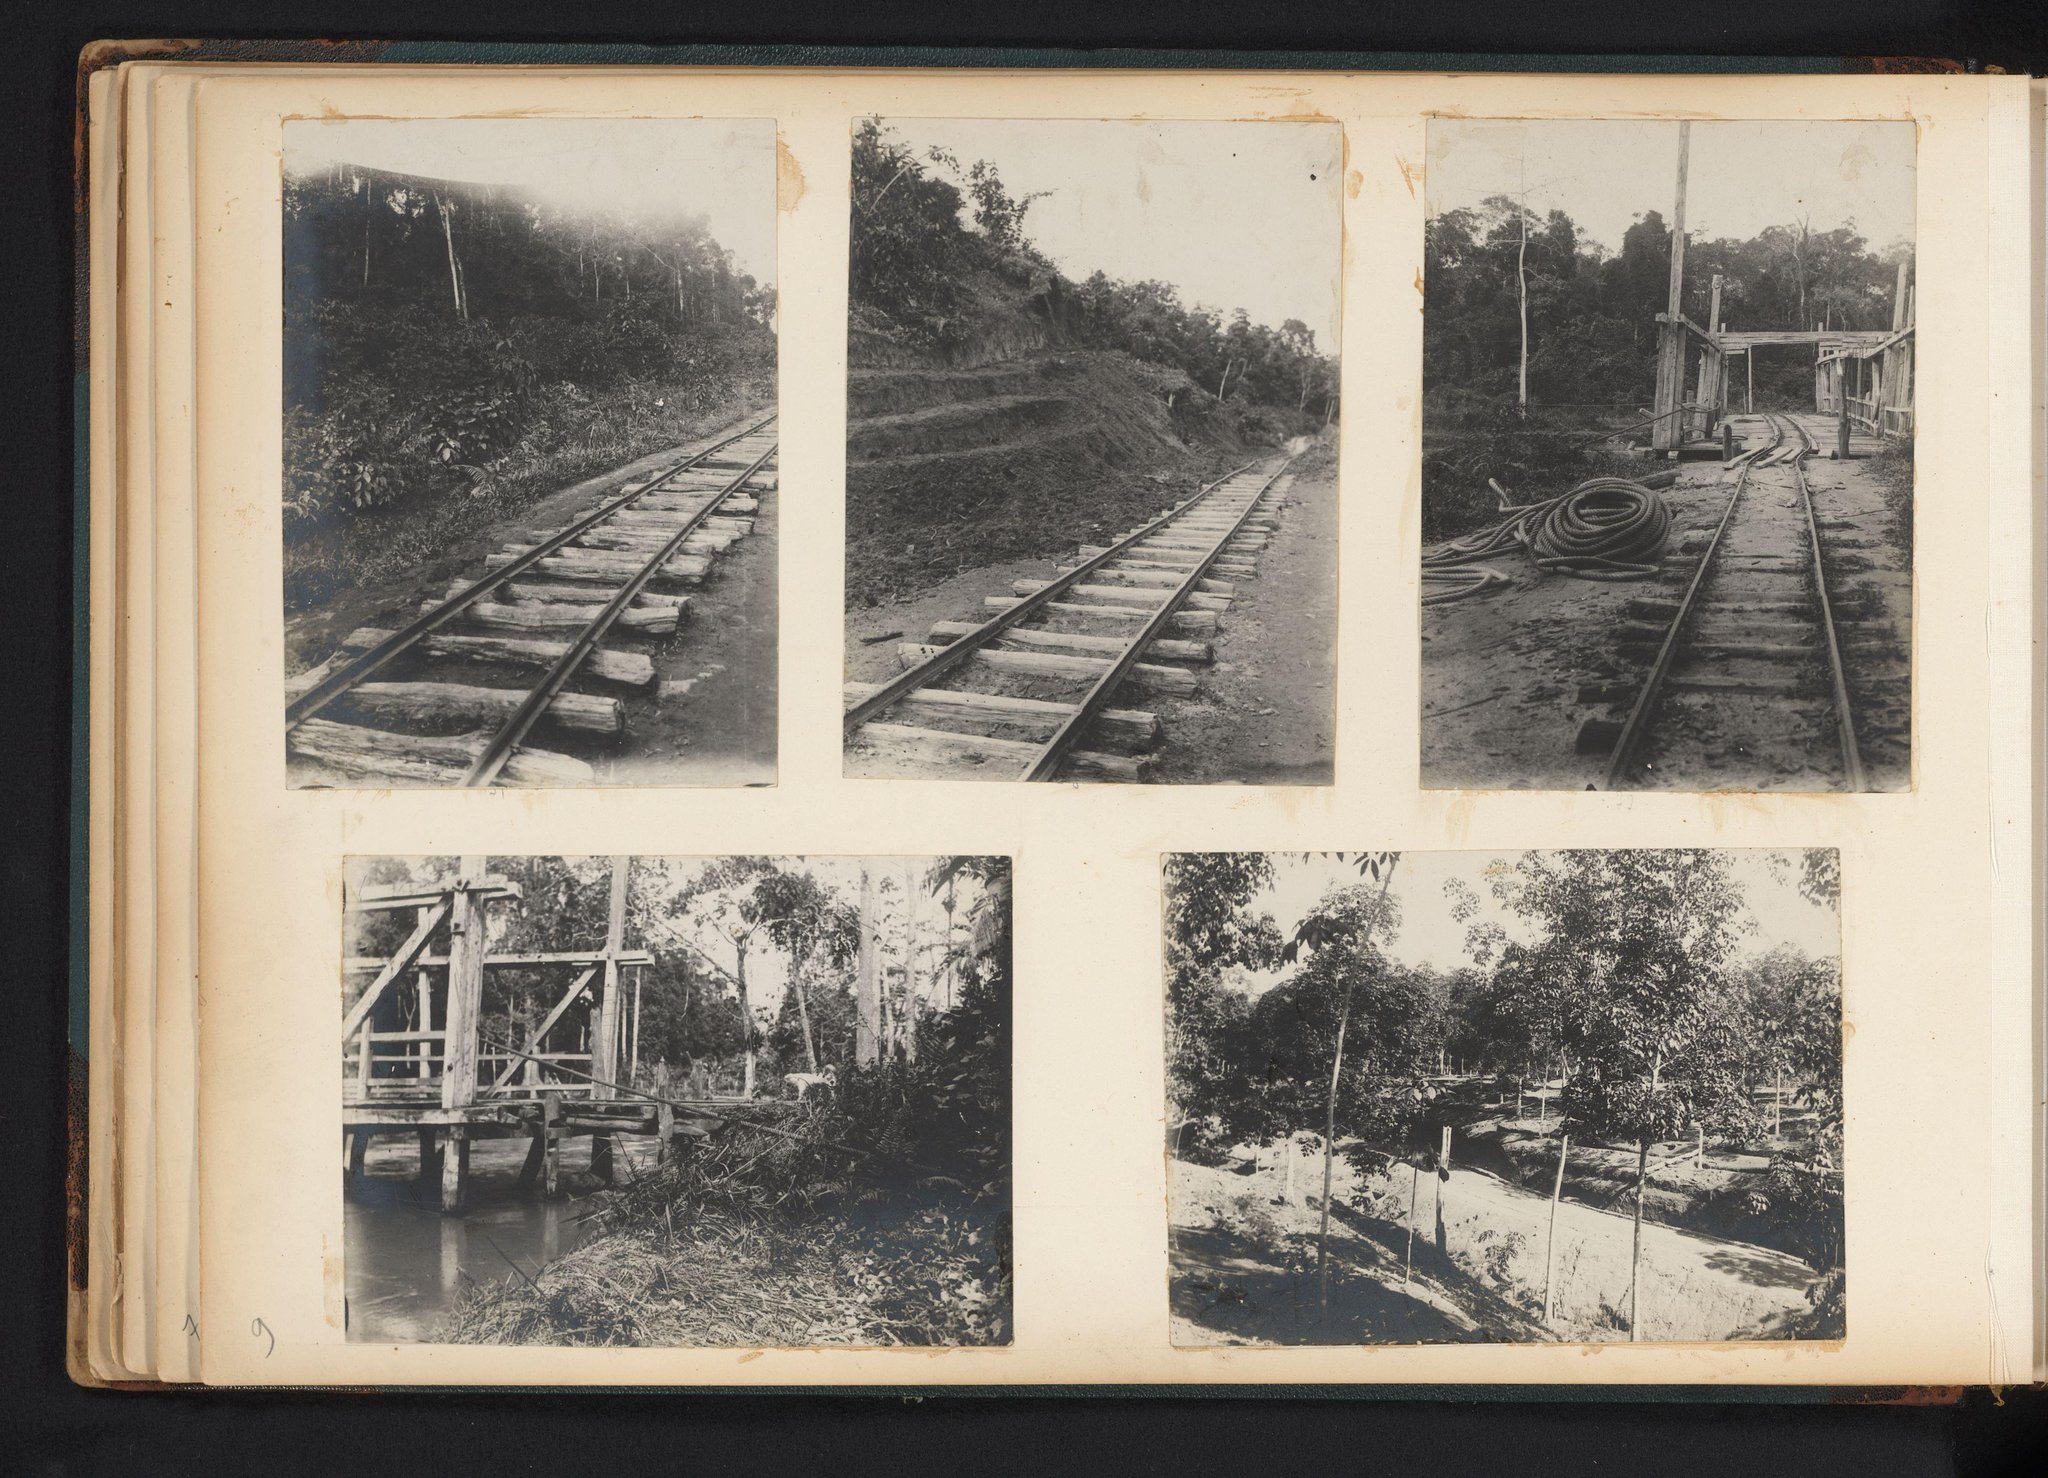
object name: photograph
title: Aanleg spoorweg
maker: Anonymous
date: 1910-1935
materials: cardboard, photographic support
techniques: gelatin silver print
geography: east sumatra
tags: plantation, (non-fruit) products of plants or trees: rubber, railway, tramway; rack railway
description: Blad met vijf foto's van een op de plantage aangelgde spoorlijn en brug. Zonder onderschriften. Onderdeel van het fotoalbum over de plantages Brussel en Pernantian van de Sumatra Caoutchouc Maatschappij op de Oostkust van Sumatra in de jaren 1910-1935.